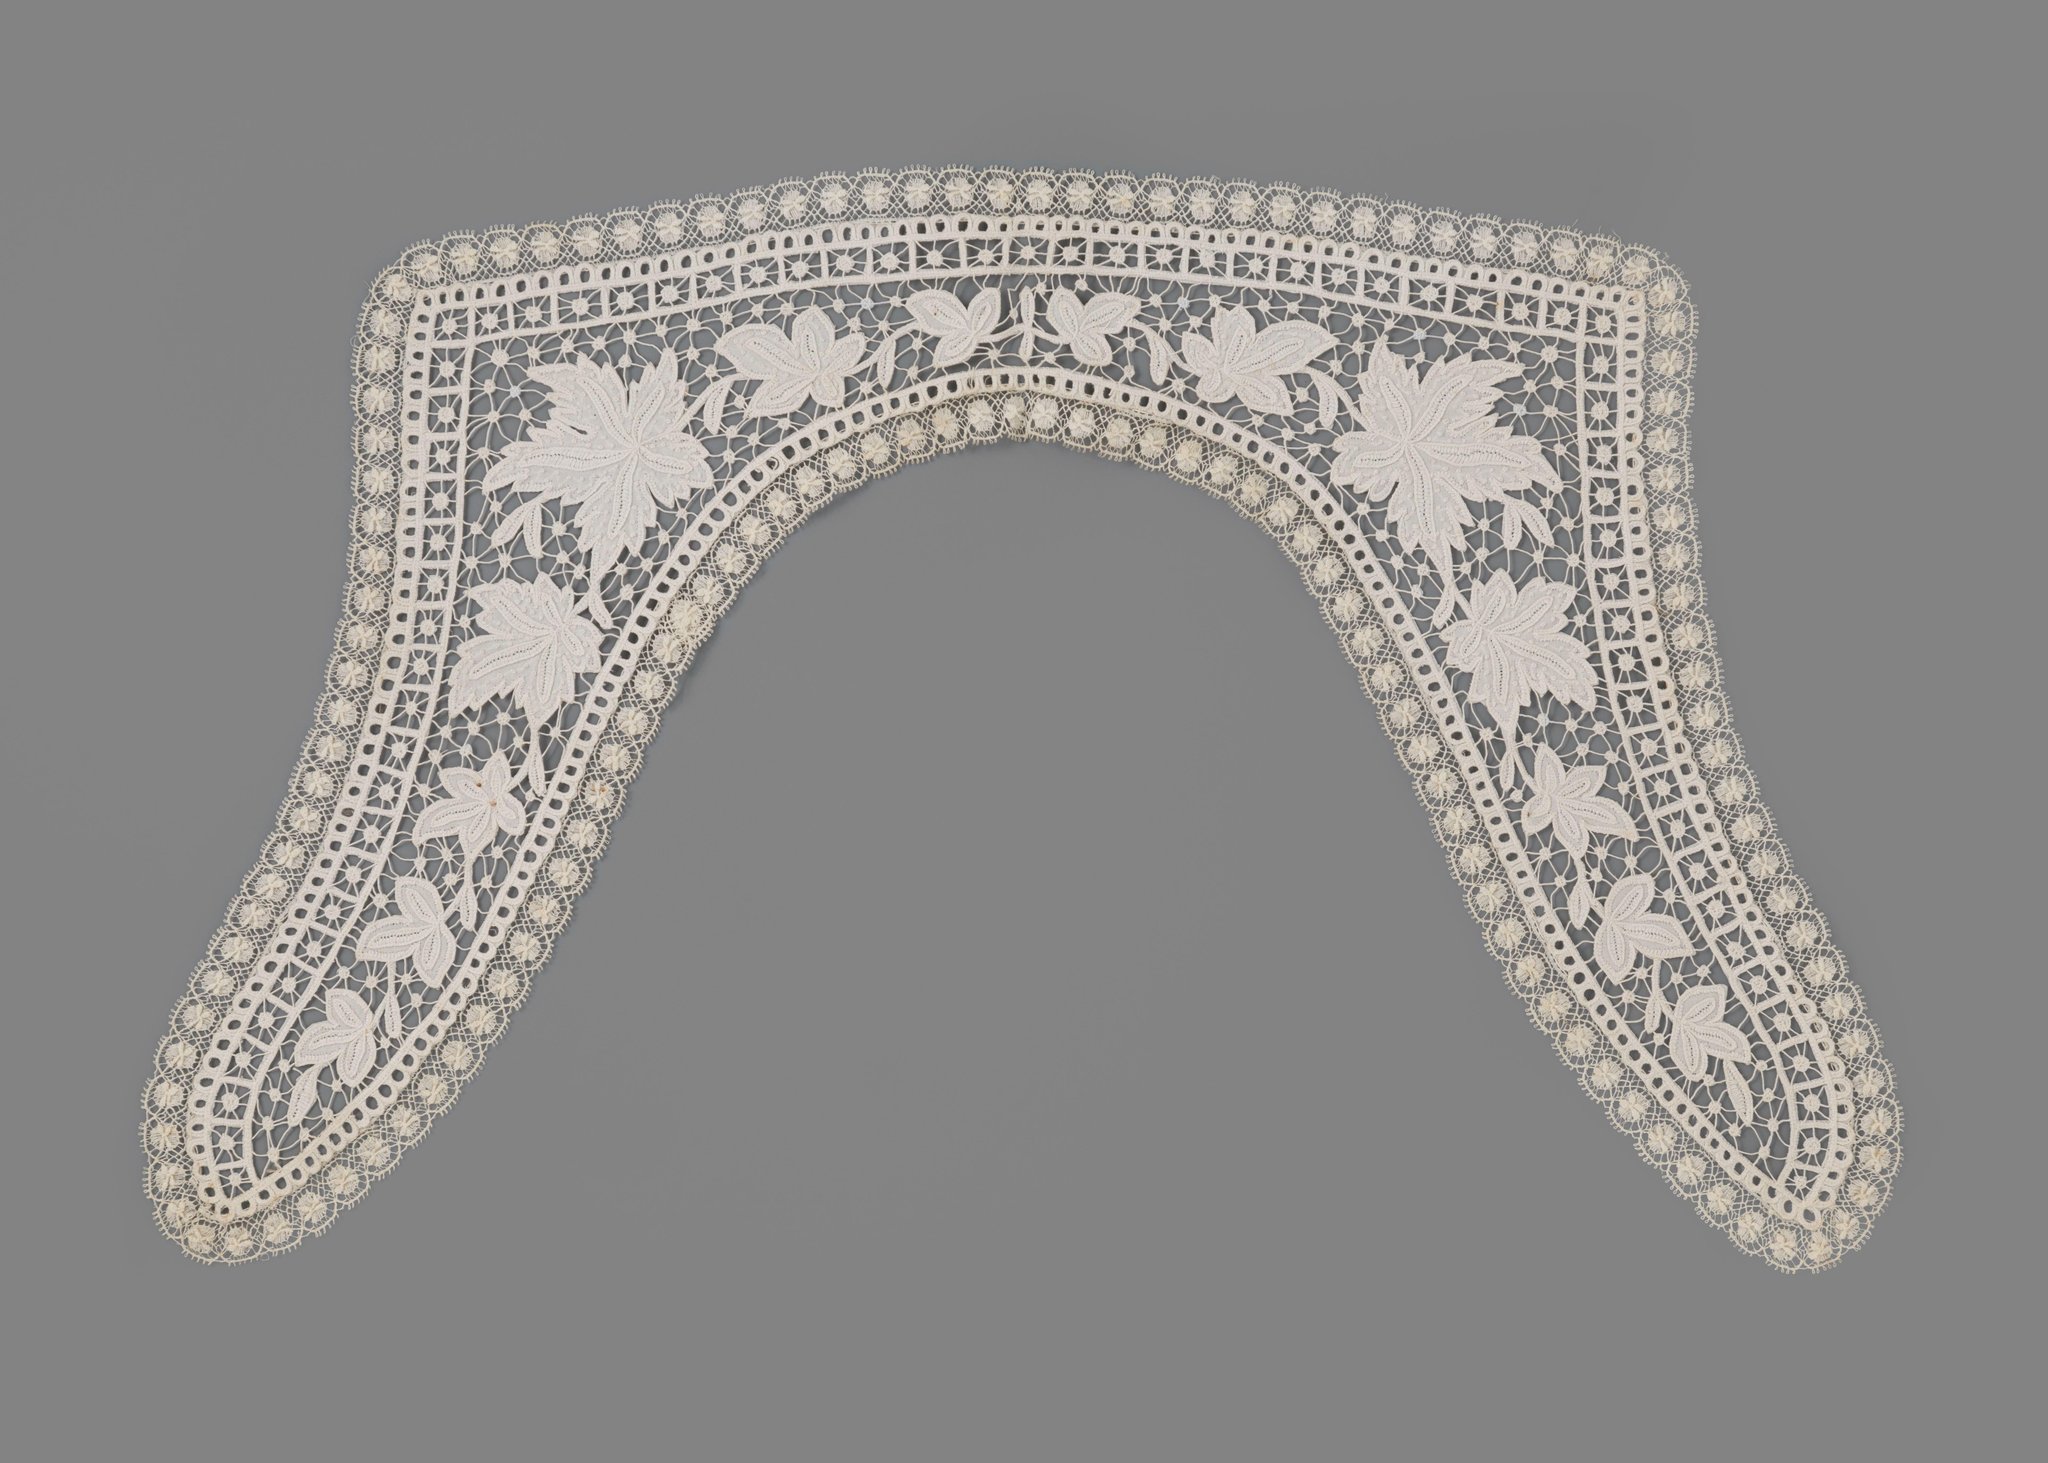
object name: collar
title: Kraag met gefestonneerde bladeren tussen spinnen gevat in een rand van gefestonneerde vierkanten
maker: Anonymous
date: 1865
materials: linen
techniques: festooning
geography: western europe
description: De kraag is recht van achteren en heeft van voren twee slippen. Het bestaat uit symmetrisch geplaatste bladeren van binnen, gefestonneerd en geborduurd, die door spinnen verbonden zijn. De rand is van gefestonneerde vierkanten en schulpen, omzoomd door een machinale kant.